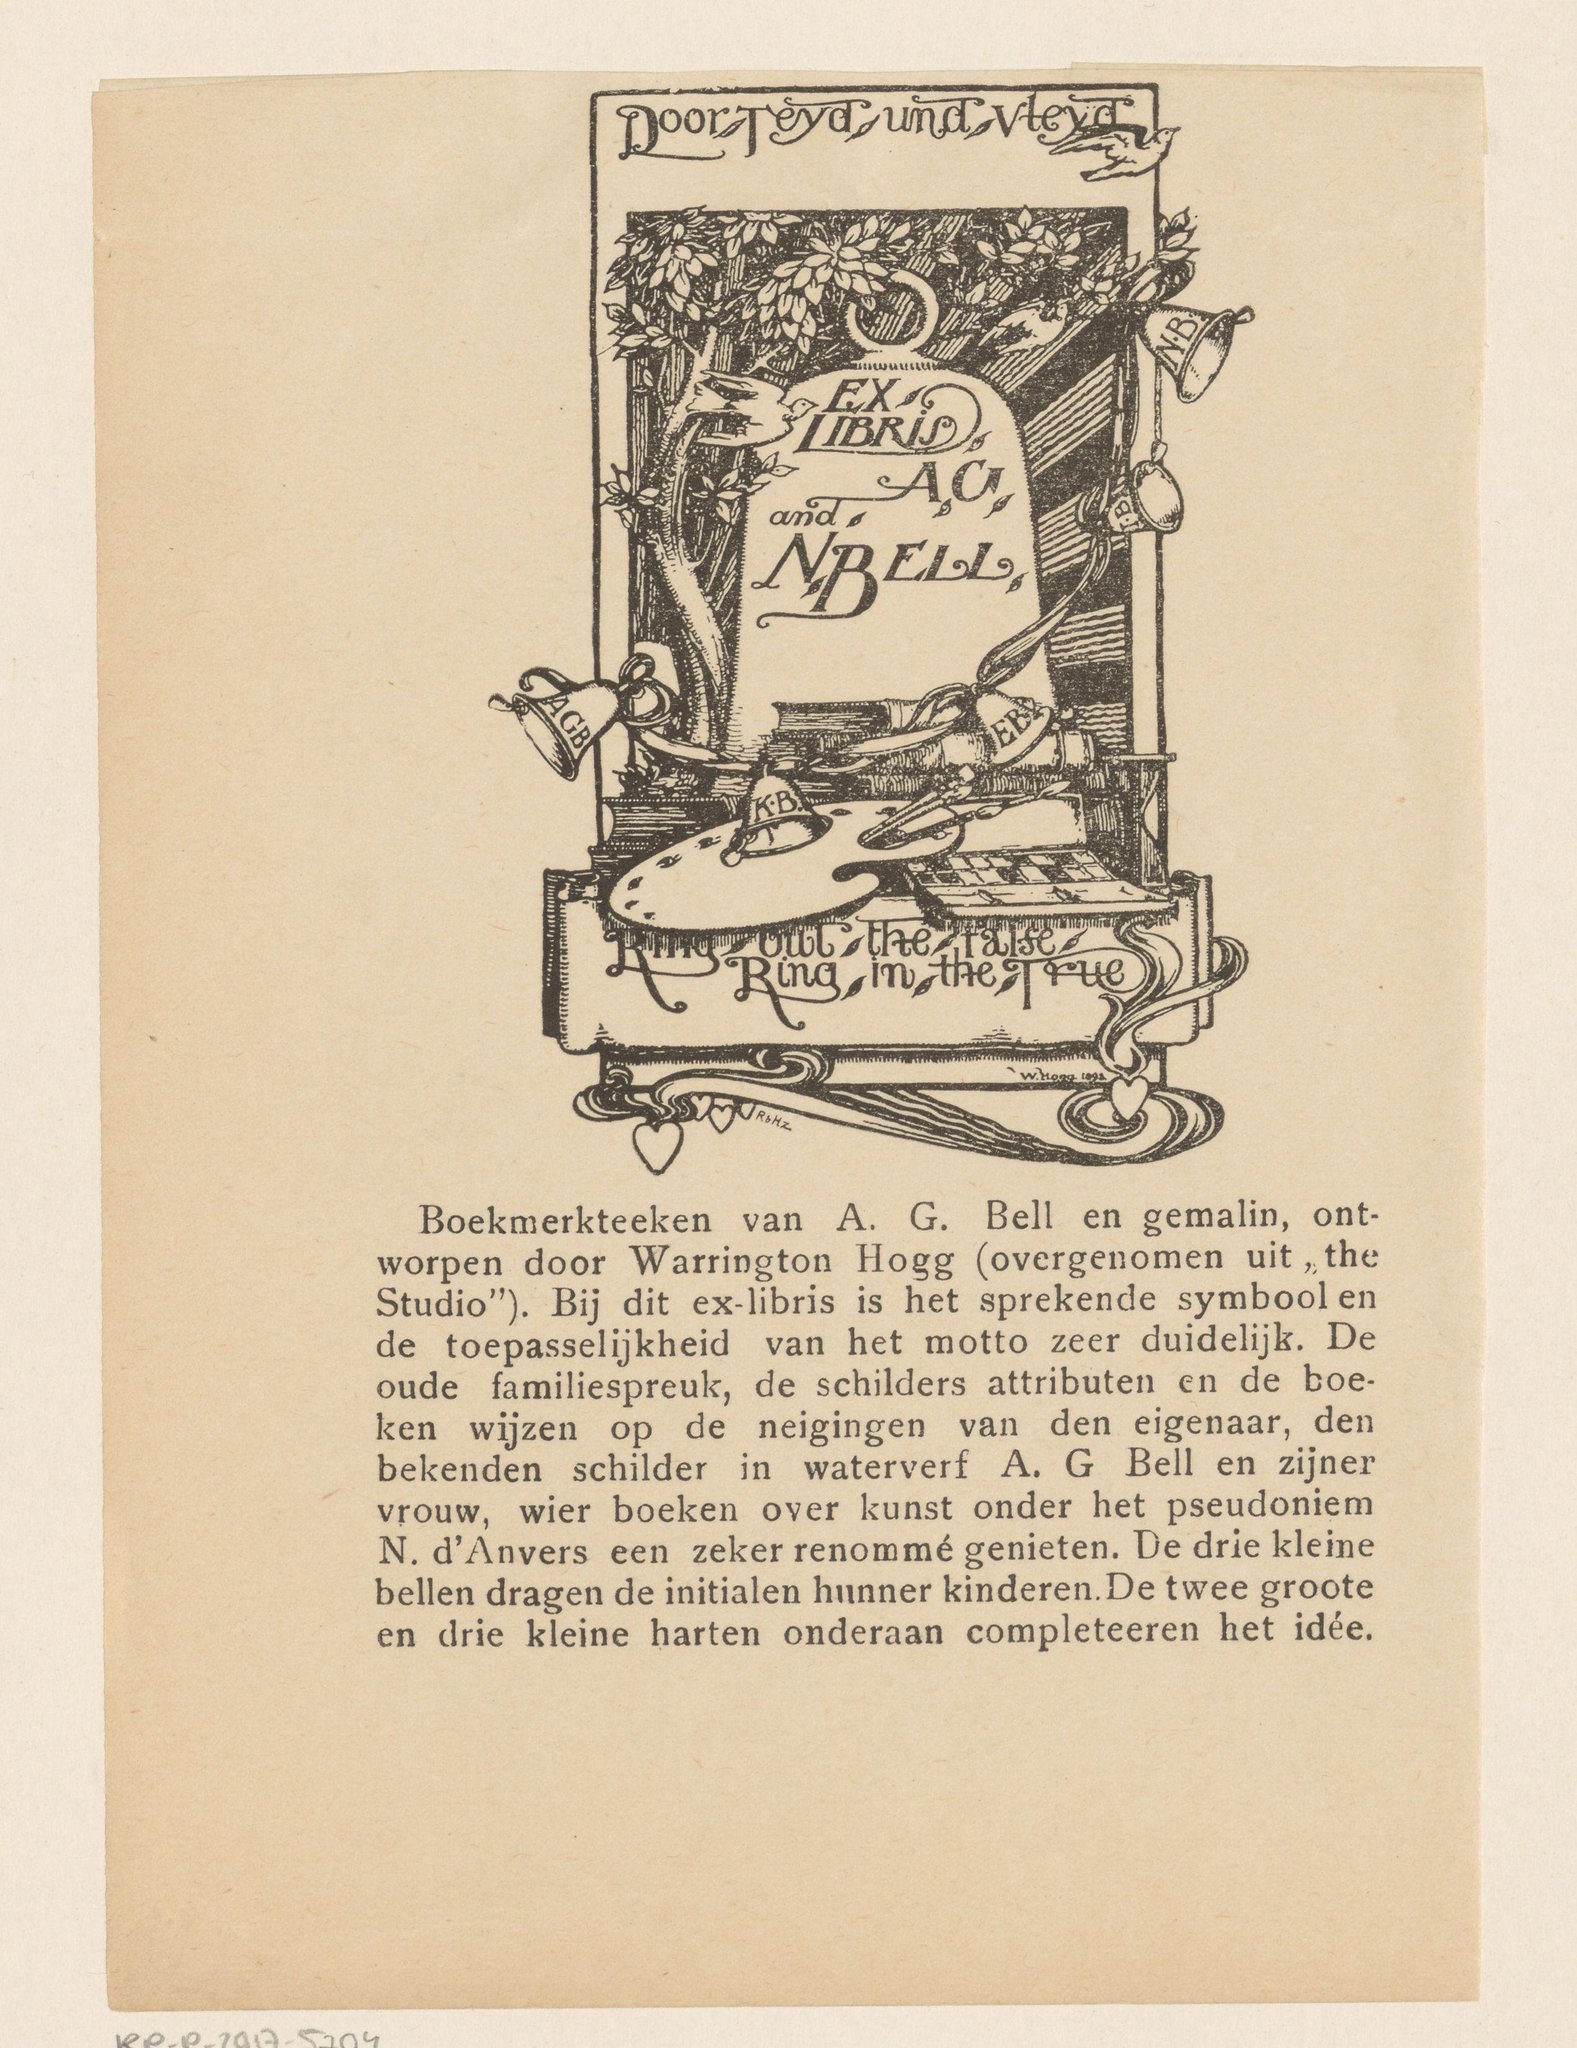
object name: bookplate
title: Ring out the false, ring in the true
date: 1892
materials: paper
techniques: letterpress printing, printing block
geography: england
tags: painter, trees, bell ~ musical instruments, book, palette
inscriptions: date